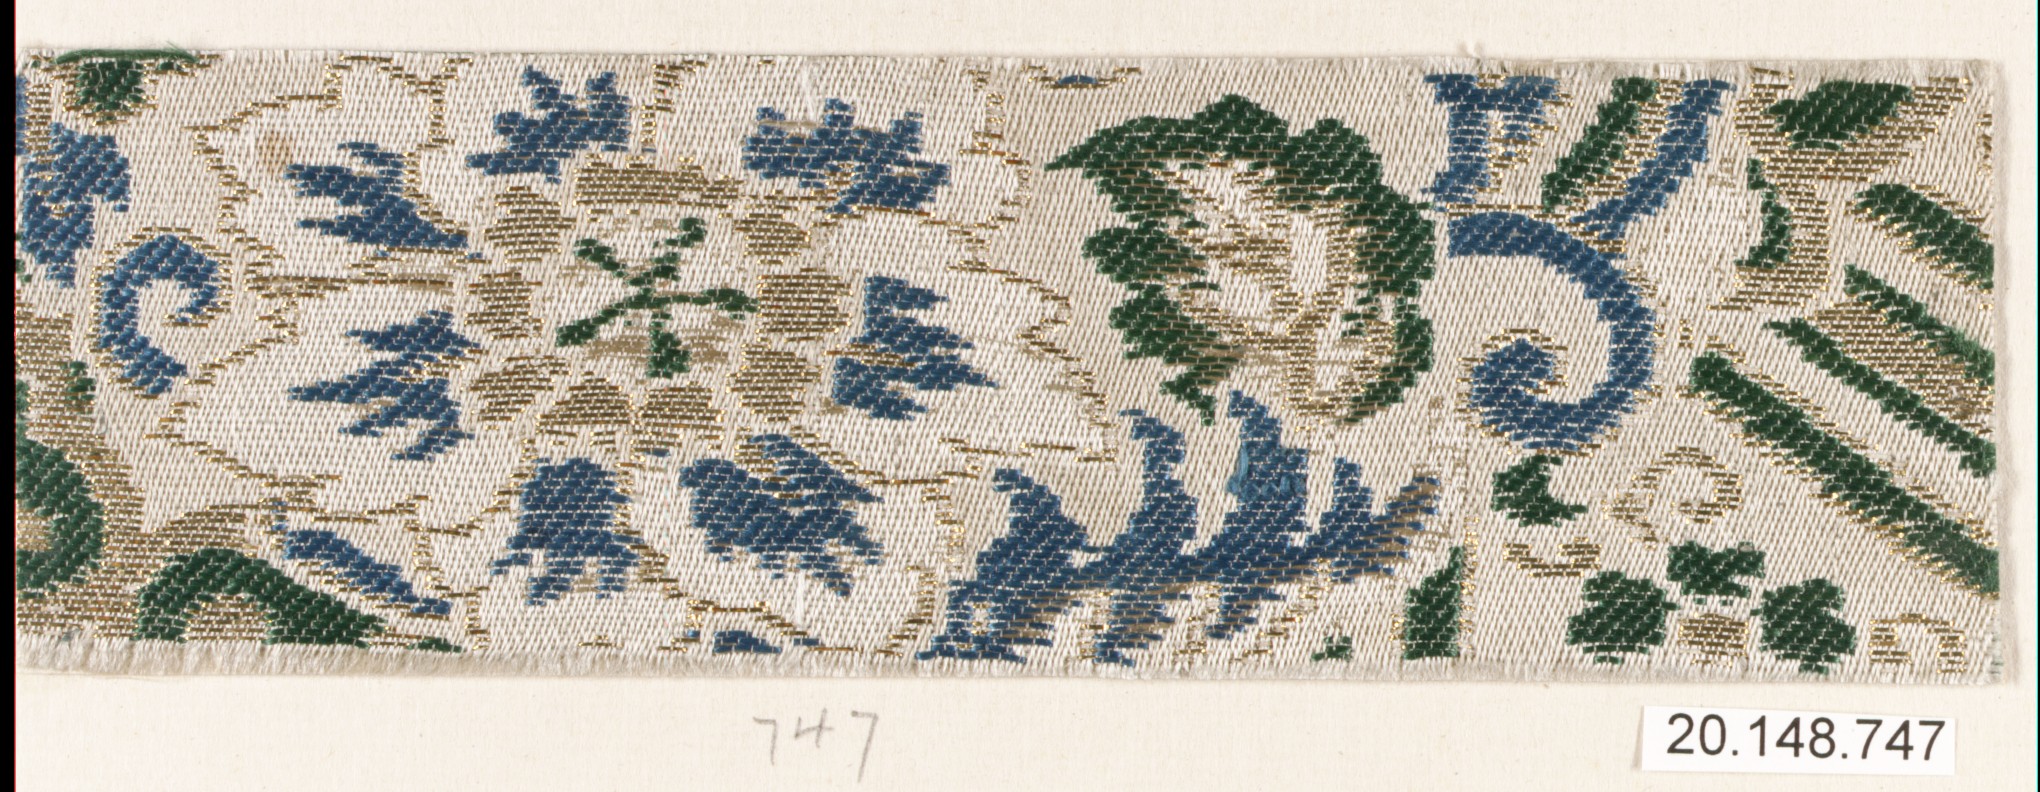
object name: piece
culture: japanese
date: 1601-1700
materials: silk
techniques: compound weave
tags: flowers,leaves